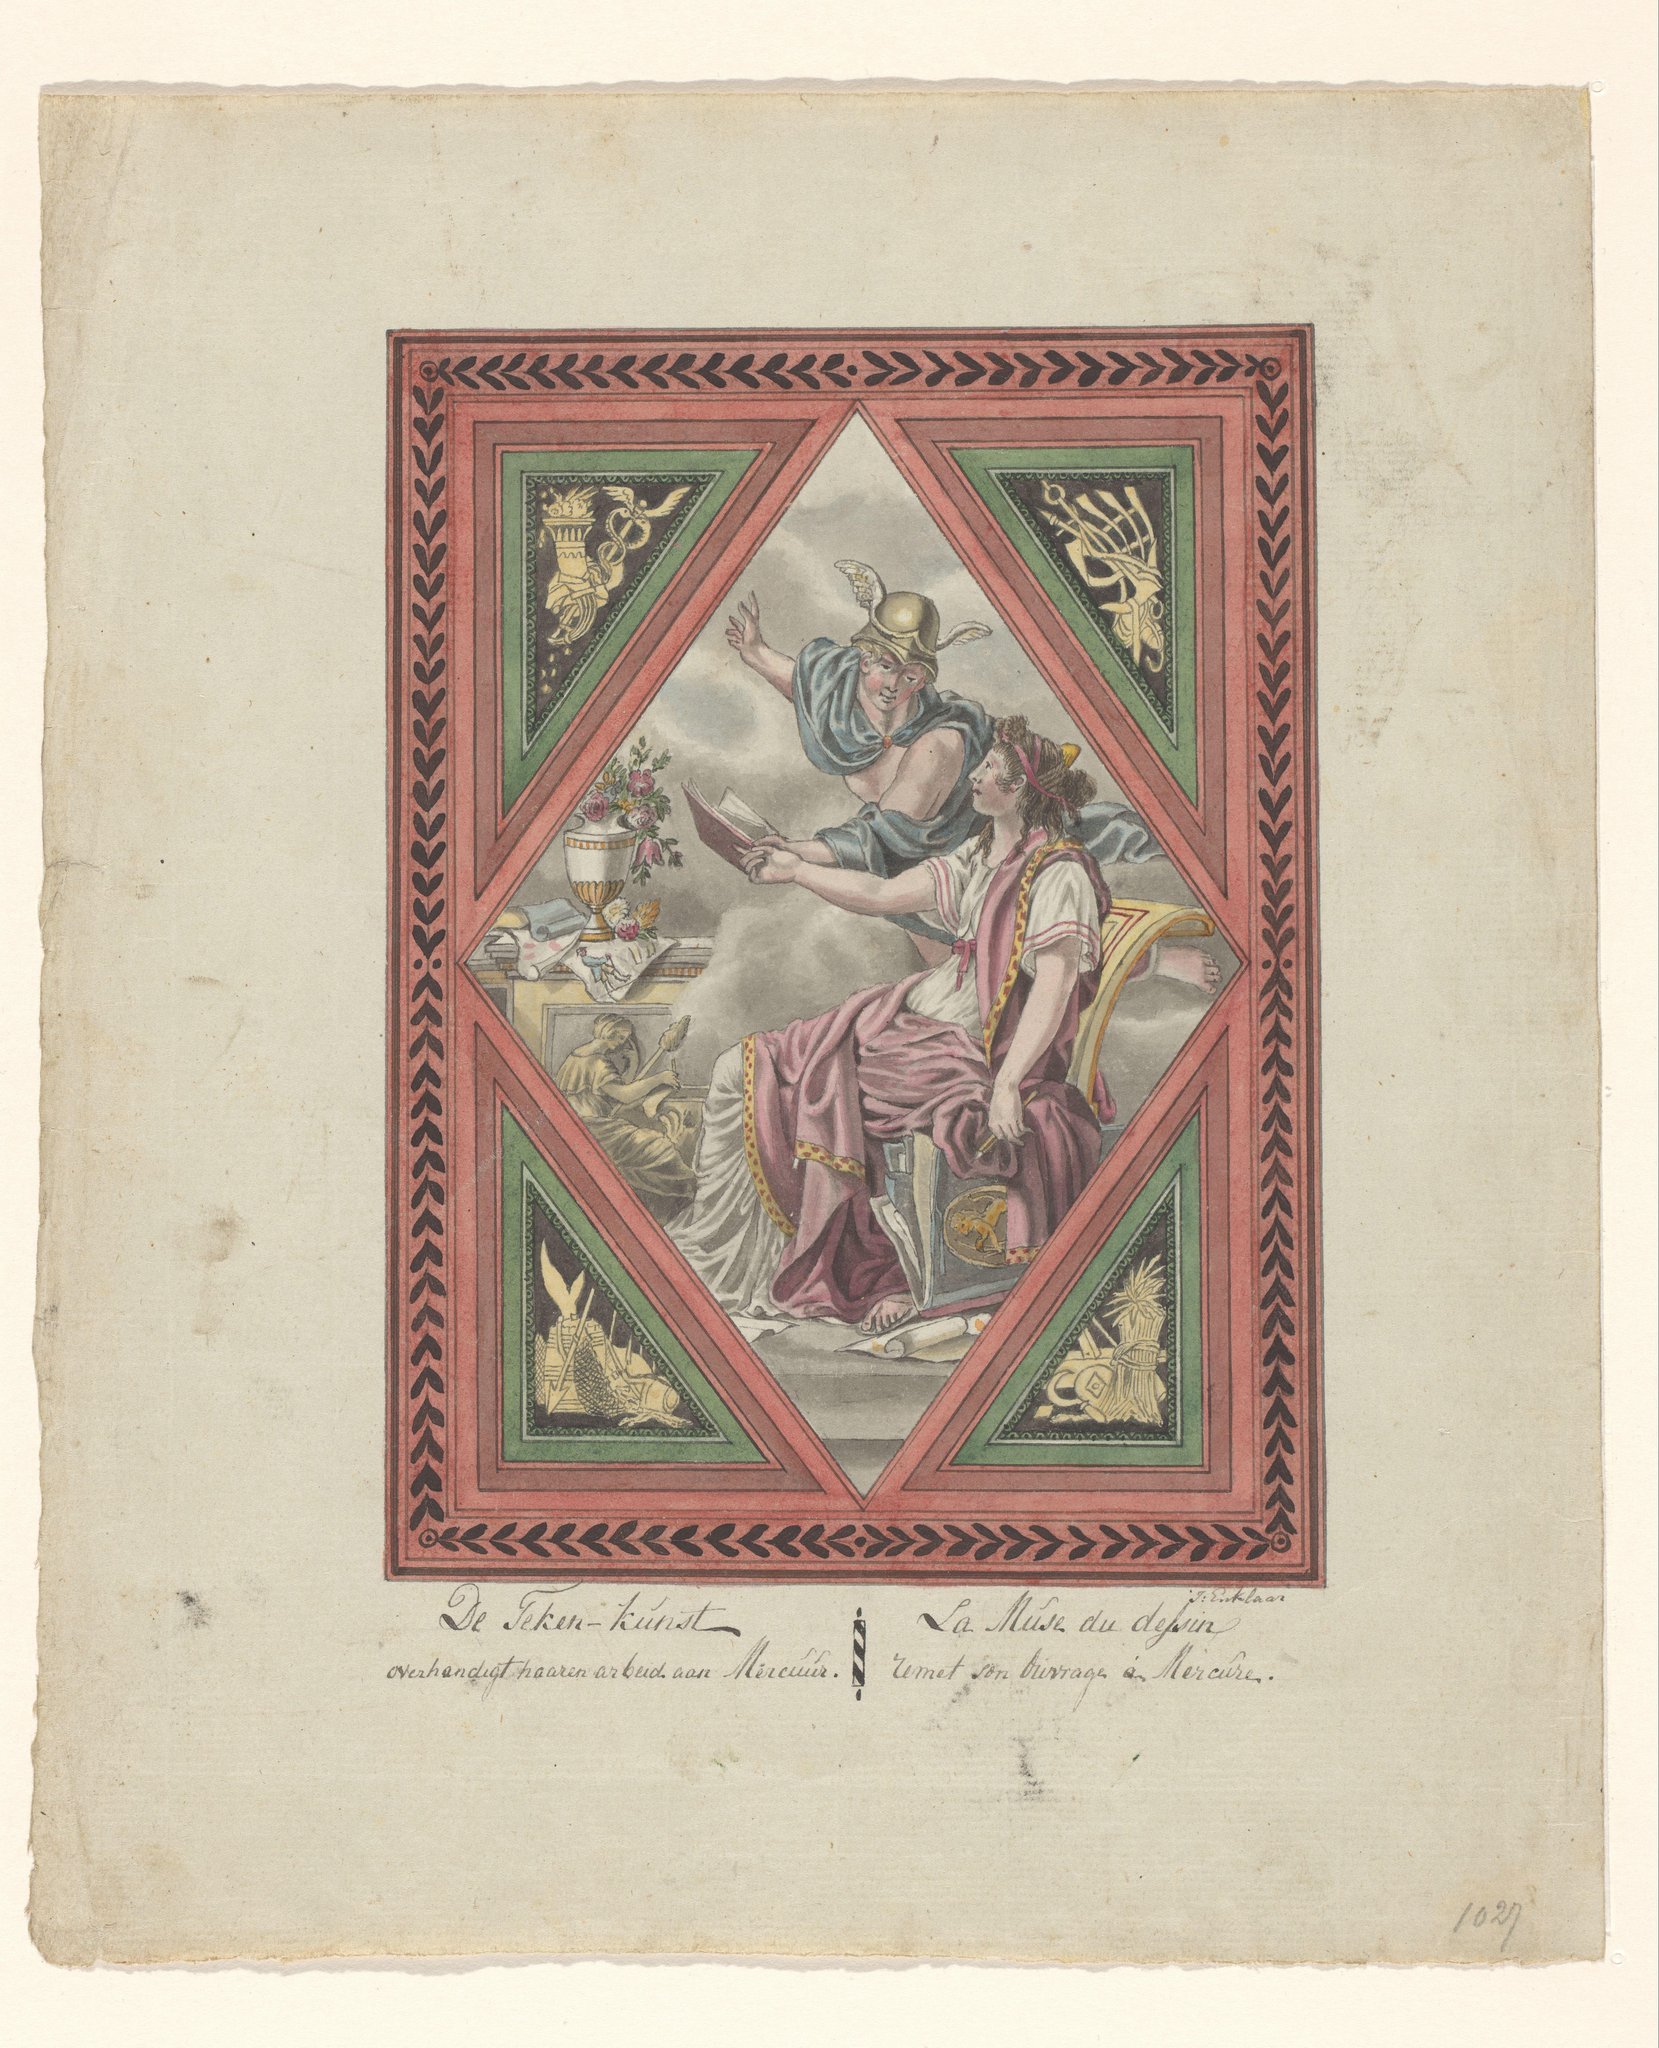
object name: drawing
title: De Teken-kunst overhandigt haaren Arbeid aan Mercuur / La Muse du dessin remet son Ouvrage à Mercure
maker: j. enklaar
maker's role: draughtsman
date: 1803-1899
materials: ink, paper, watercolor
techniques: brush, pen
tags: symbolic representations, allegories and emblems ~ drawing, specific aspects, allegorical aspects of mercury; mercury as patron - veneration, honoured by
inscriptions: number: ‘1027’, inscription: ‘Gehele serie/ naar L. Portman, (Maaskamp editie)/ zie Bibliotheek 31D19/ (16 van de 20 stuks)’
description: De personificatie van de Tekenkunst toont een schetsboek met haar werk aan Mercurius. Ze heeft een potlood in haar hand en naast haar staat een tekenmap op de grond met op het omslag het wapen van de Bataafsche Republiek. Ruitvormige voorstelling met in de vier hoeken van de omlijsting emblemen met de vruchten van Koophandel, Zeevaart, Landbouw en Visserij.